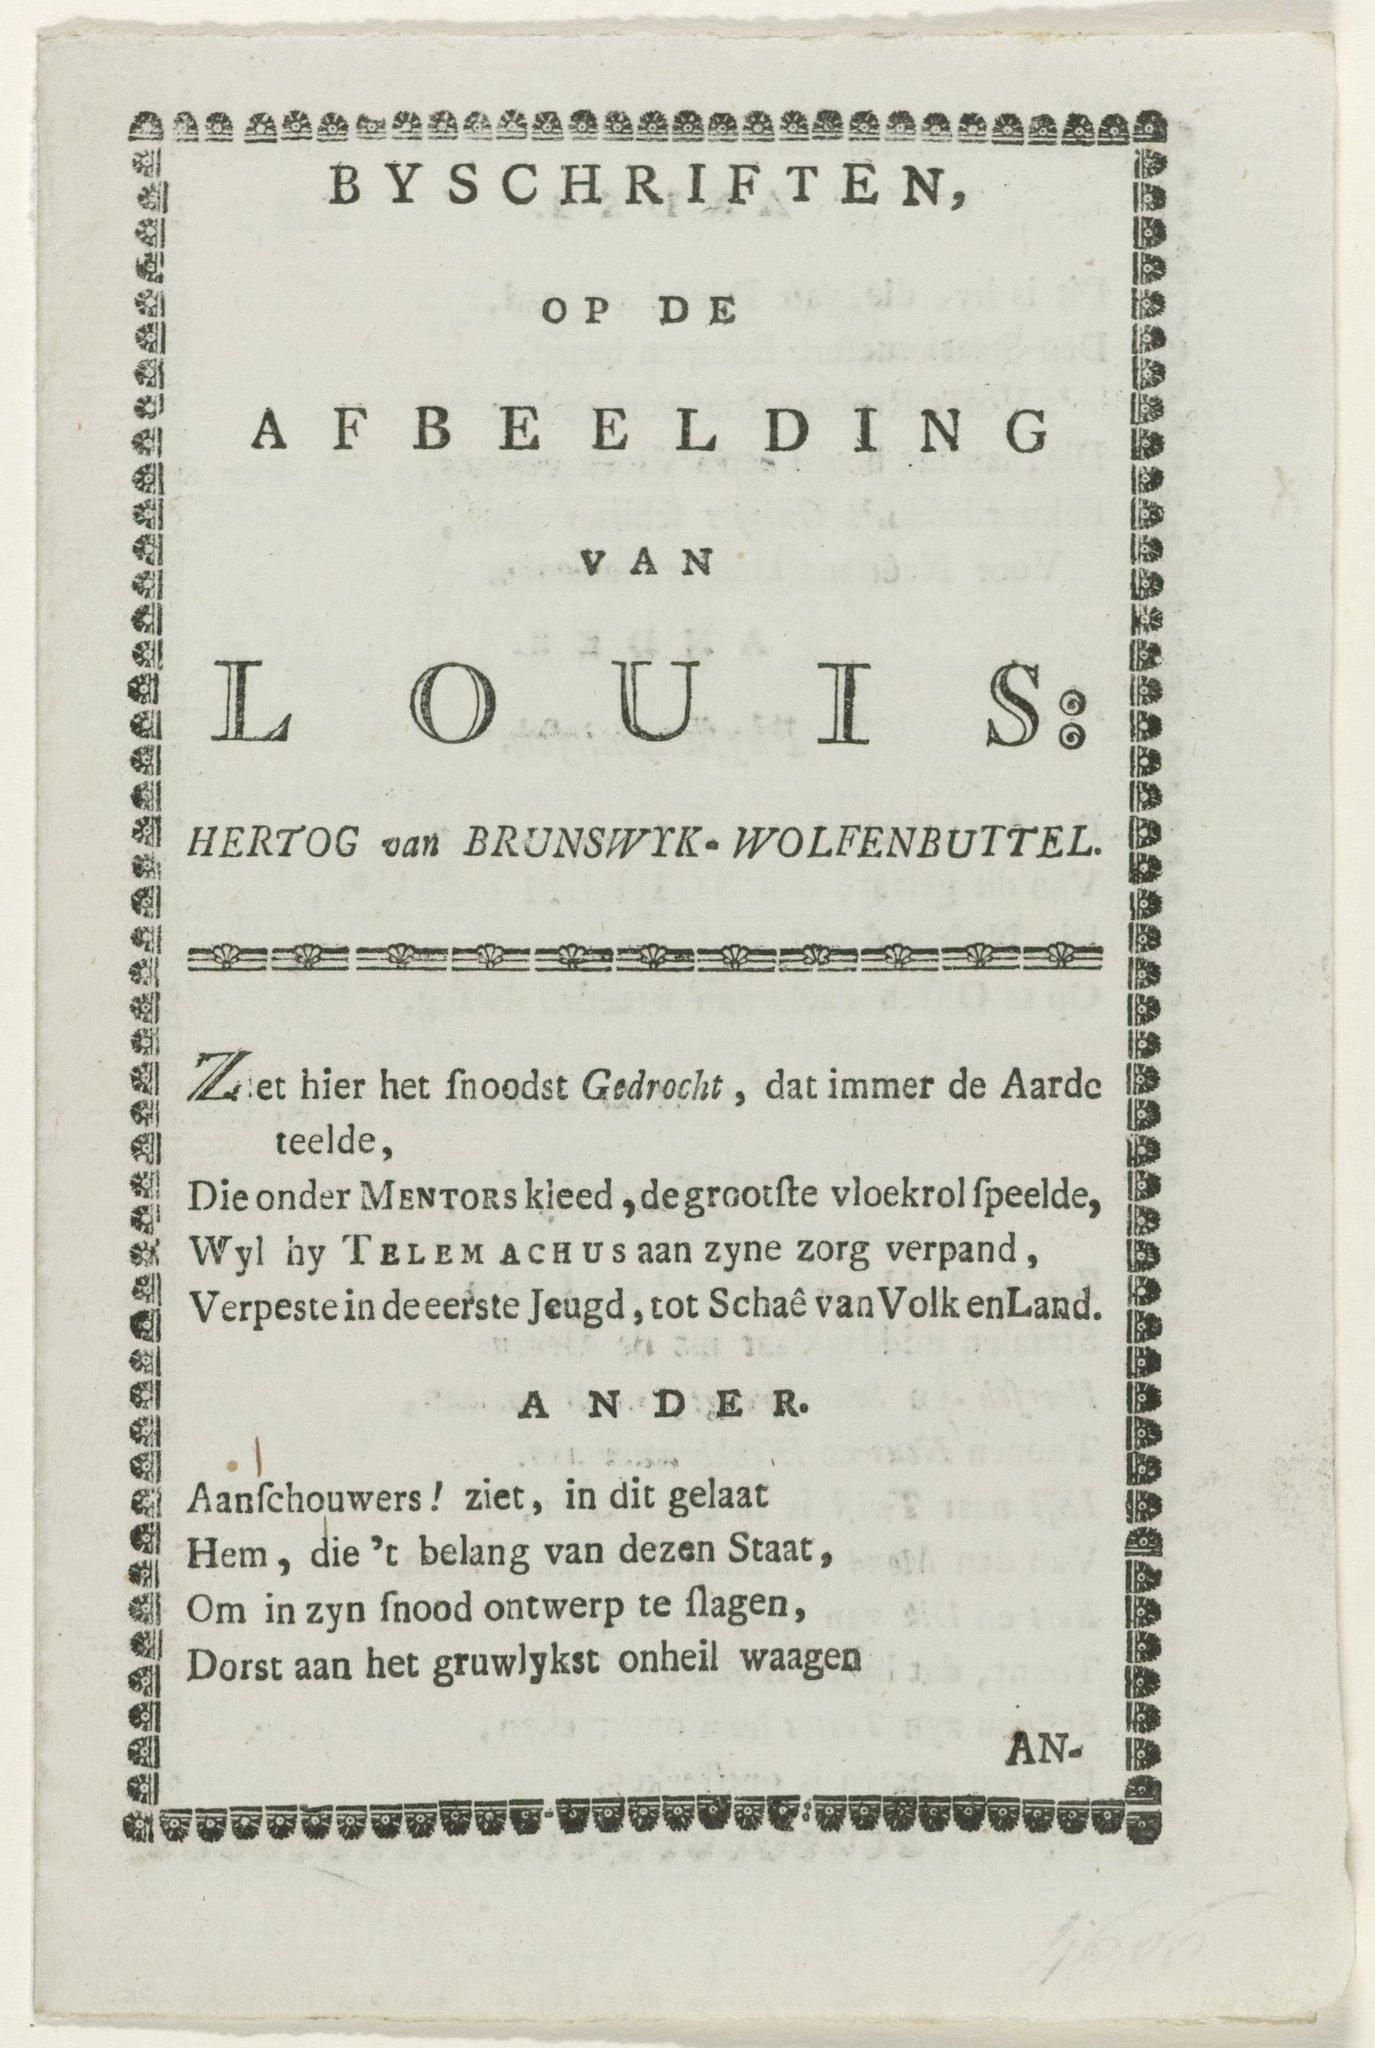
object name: text sheet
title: Byschriften, op de Afbeelding van Louis: Hertog van Brunswyk-Wolfenbuttel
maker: Anonymous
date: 1782-1783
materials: paper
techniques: letterpress printing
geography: northern netherlands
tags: william v (prince of orange), ludwig ernst von braunschweig-wolfenbüttel, patriots (1780-1795)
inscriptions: collector's mark: Lugt 2228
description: Tekstblad met spotverzen op het portret van de hertog van Brunswijk, ca. 1782-1783. Dubbelgevouwen blad bedrukt met verzen op alle zijden. In het laatste vers wordt gerefereerd aan de volgende verjaardag van de prins, 11 maart 1783.